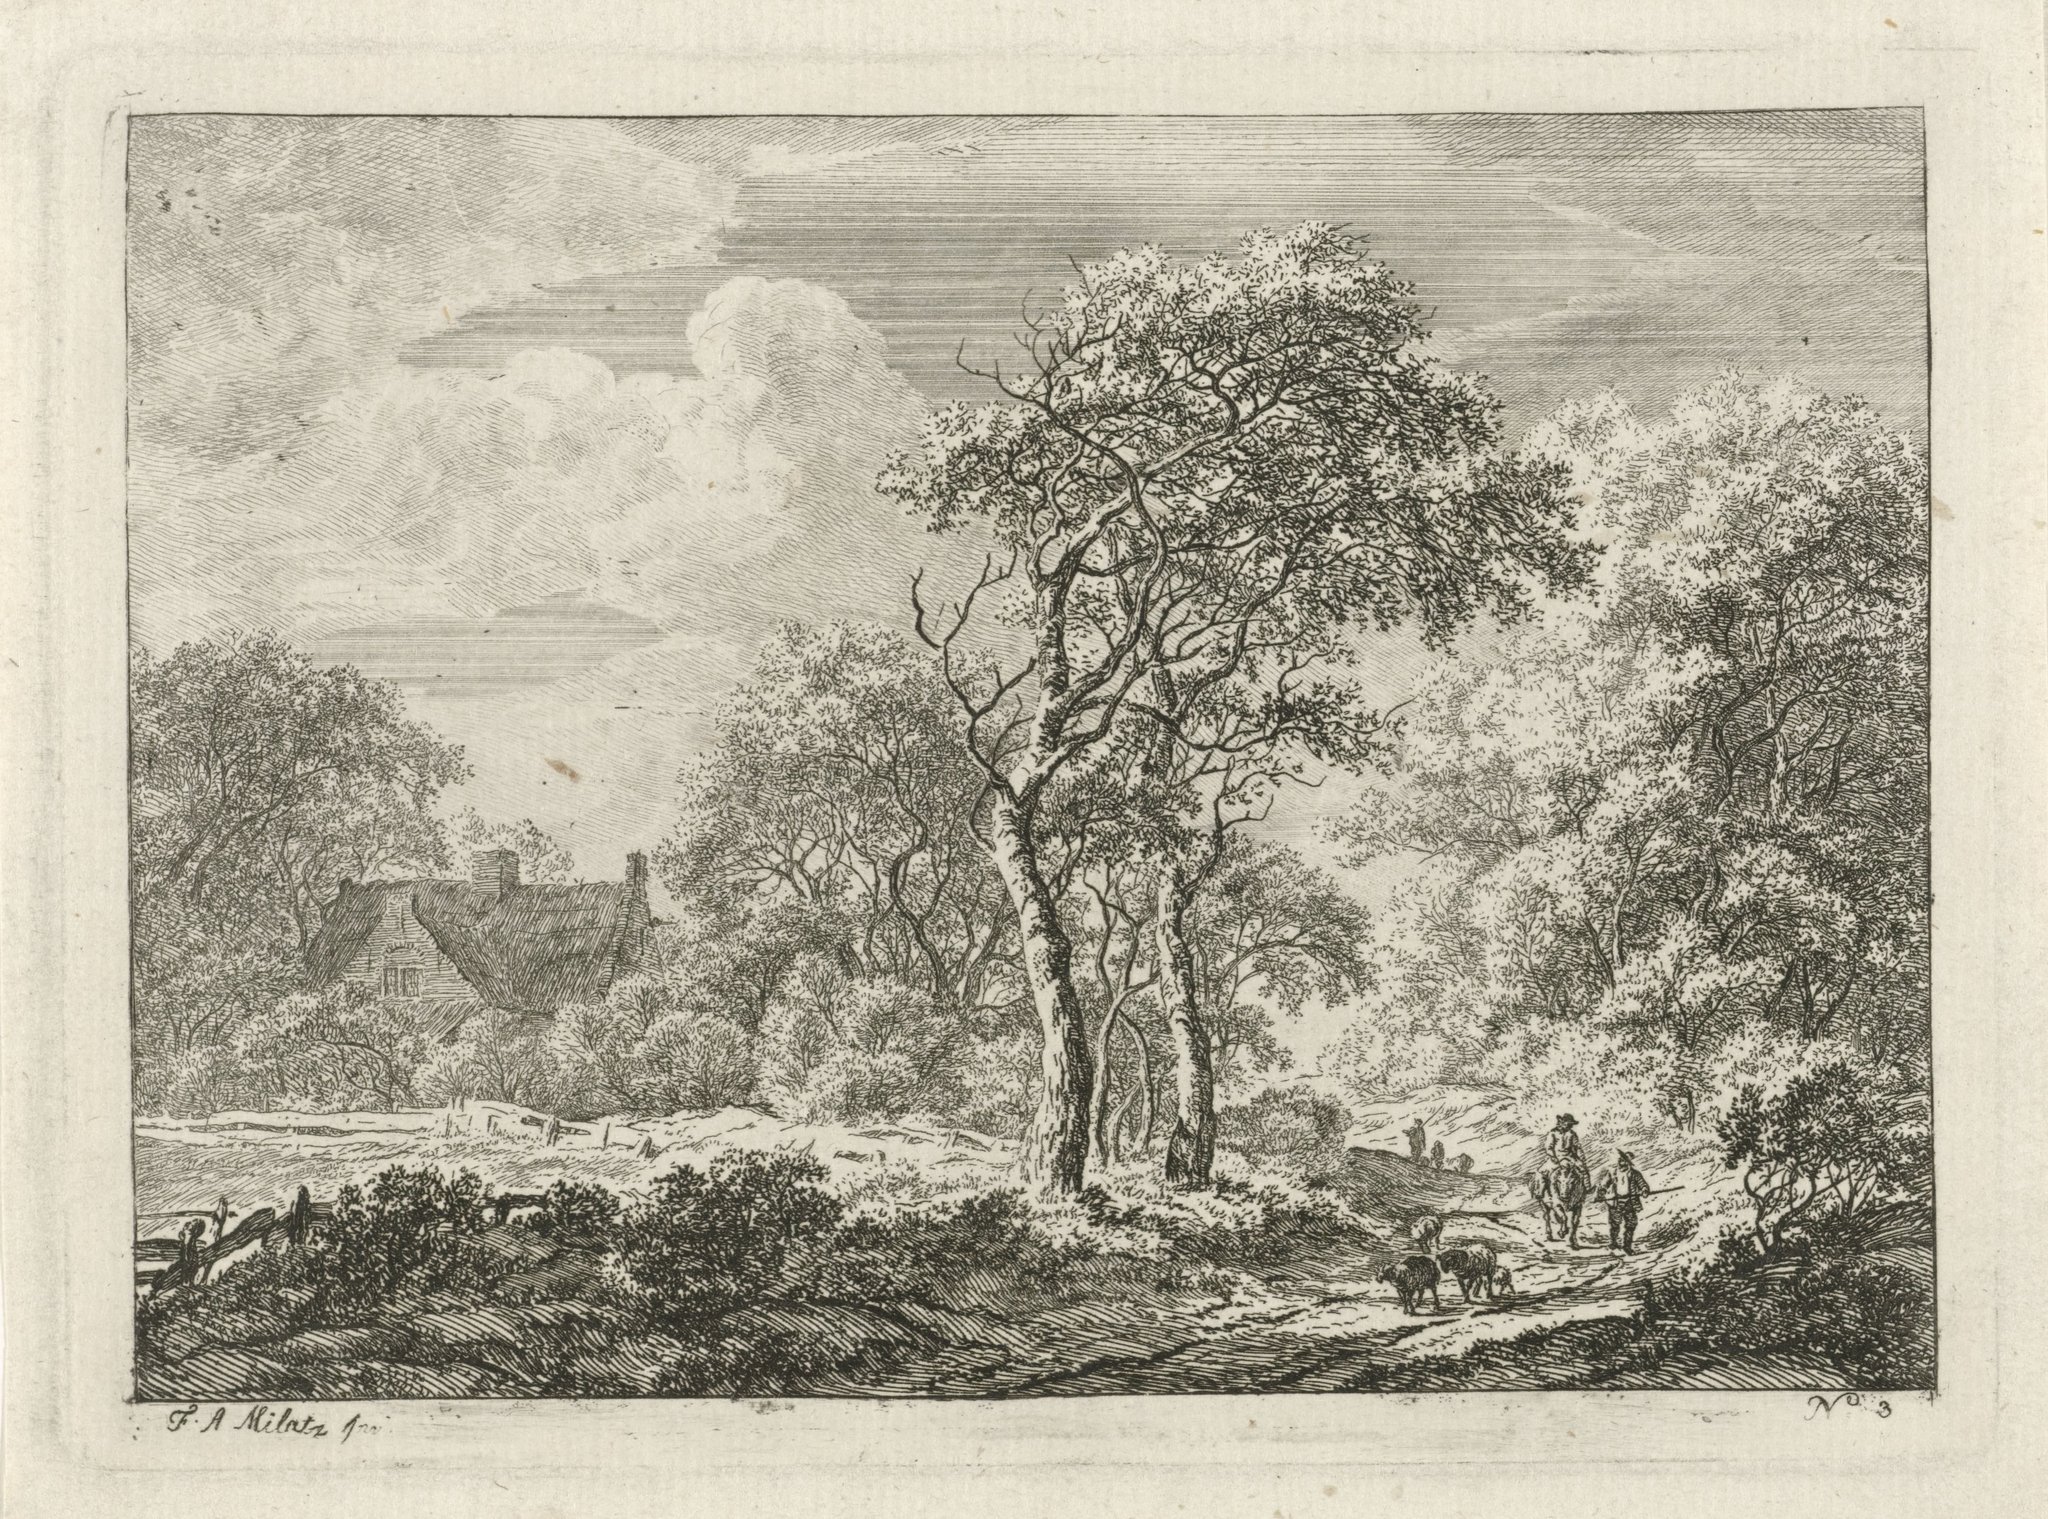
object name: print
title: Landschap met figuren op een weg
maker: franciscus andreas milatz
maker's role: draughtsman, painter, print maker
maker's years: 1764-1808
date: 1784-1808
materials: paper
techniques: etching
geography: haarlem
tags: riding a horse, ass, or mule; rider, horseman, trees, landscapes in the temperate zone, cattle driving, cattle driver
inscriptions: collector's mark: Lugt 2228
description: Boomrijk landschap met rechts een ruiter en een lopende man op een weg. Voor hen uit schapen. Links tussen de bomen een huis.